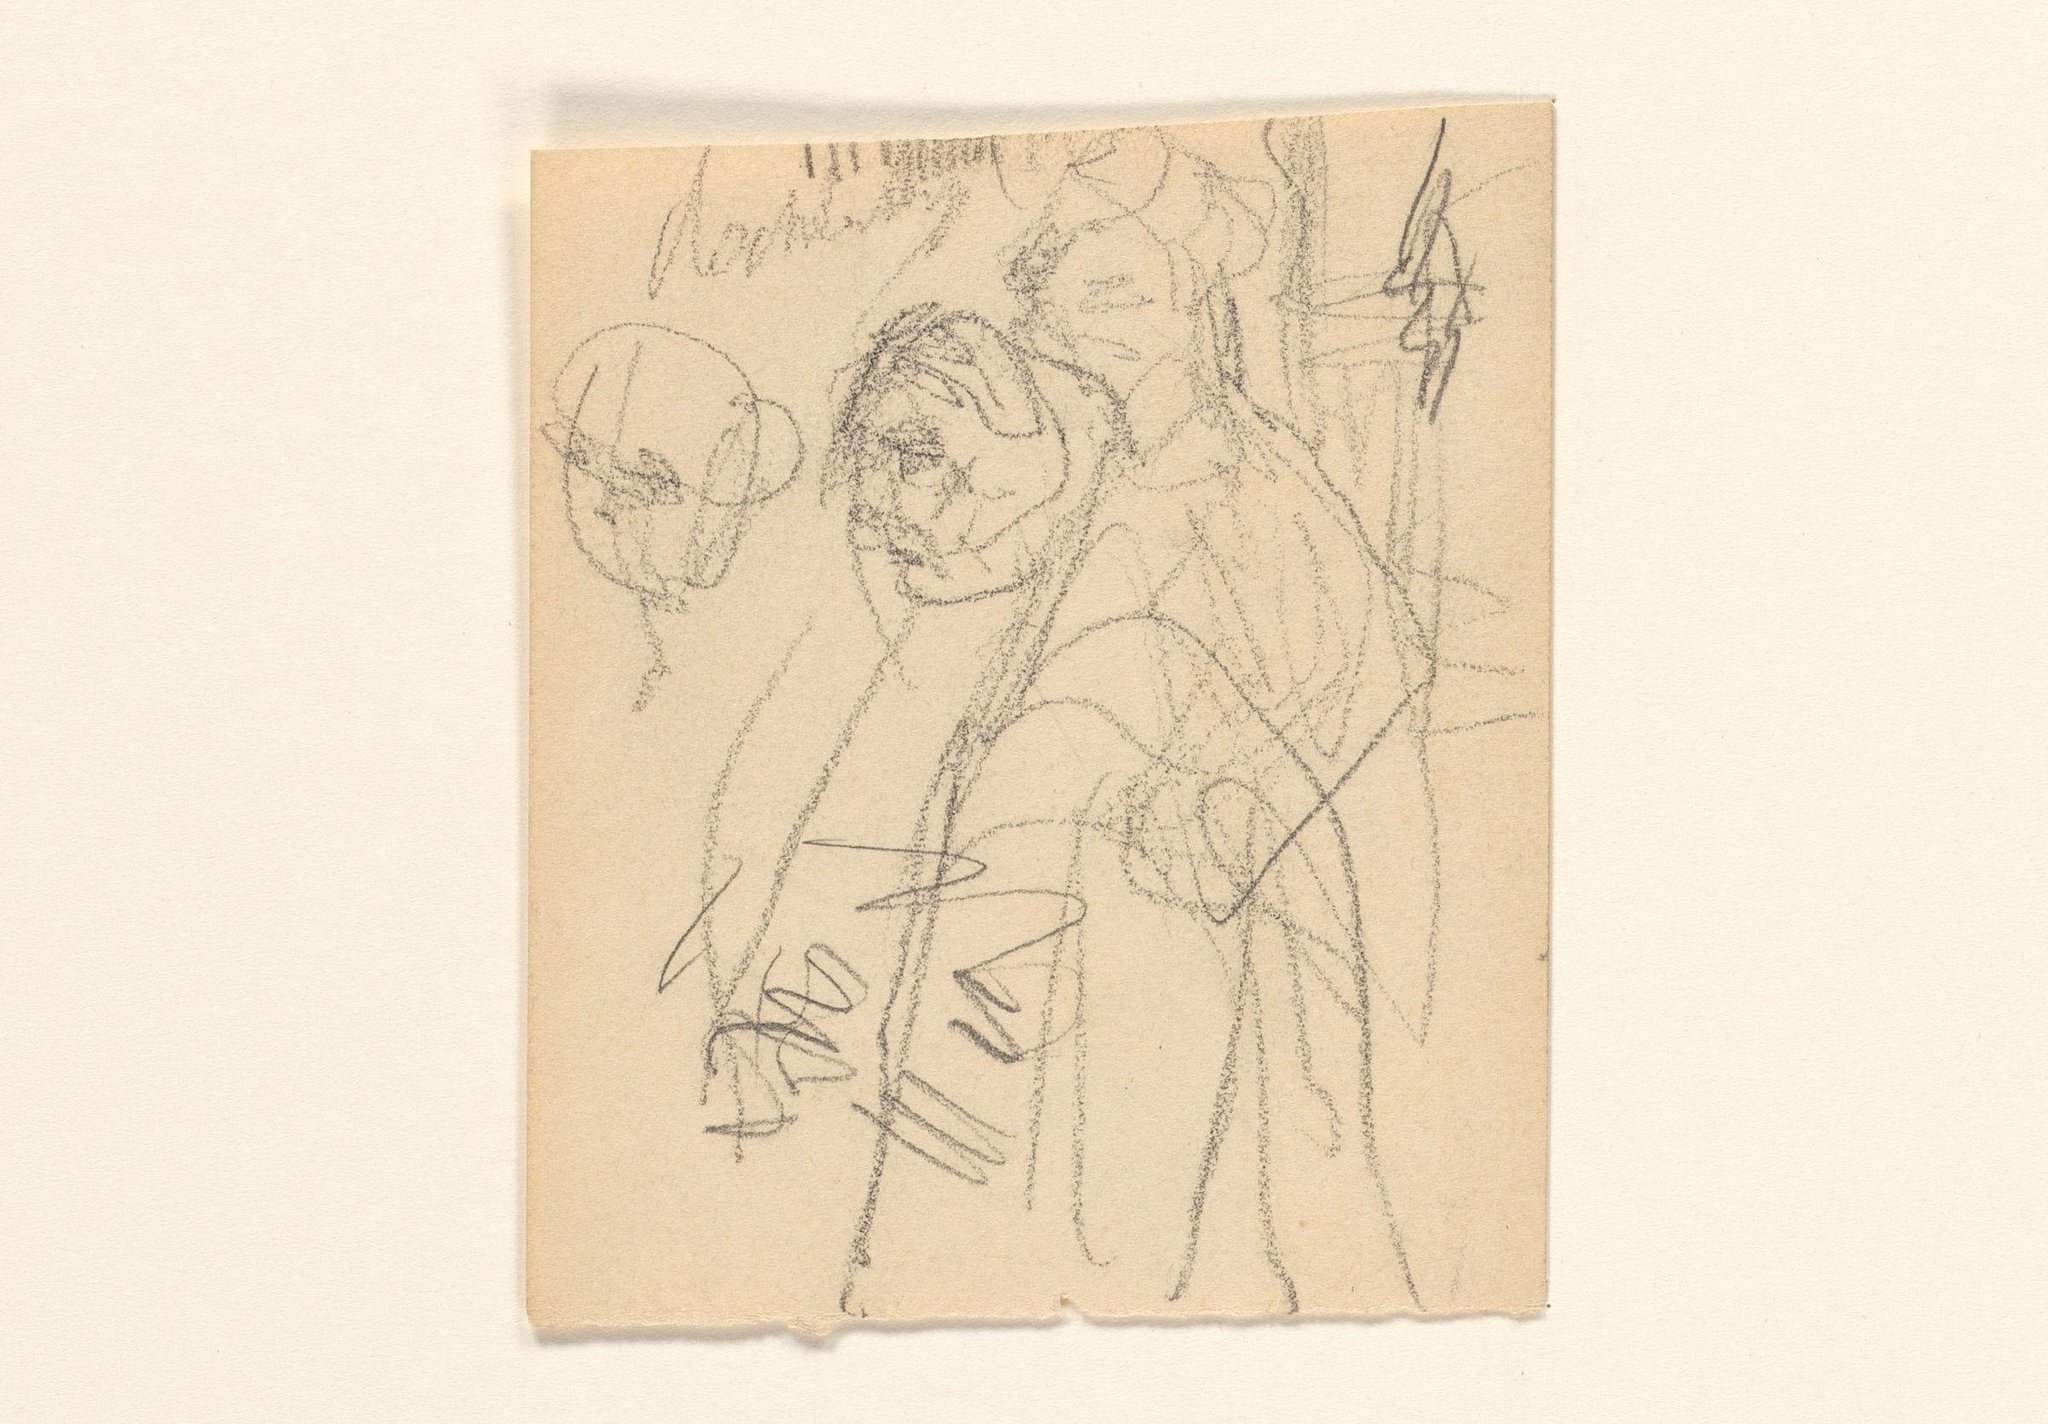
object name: drawing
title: Schets met enkele figuren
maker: august allebé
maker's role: draughtsman, print maker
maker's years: 1838-1927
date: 1848-1927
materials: chalk, paper